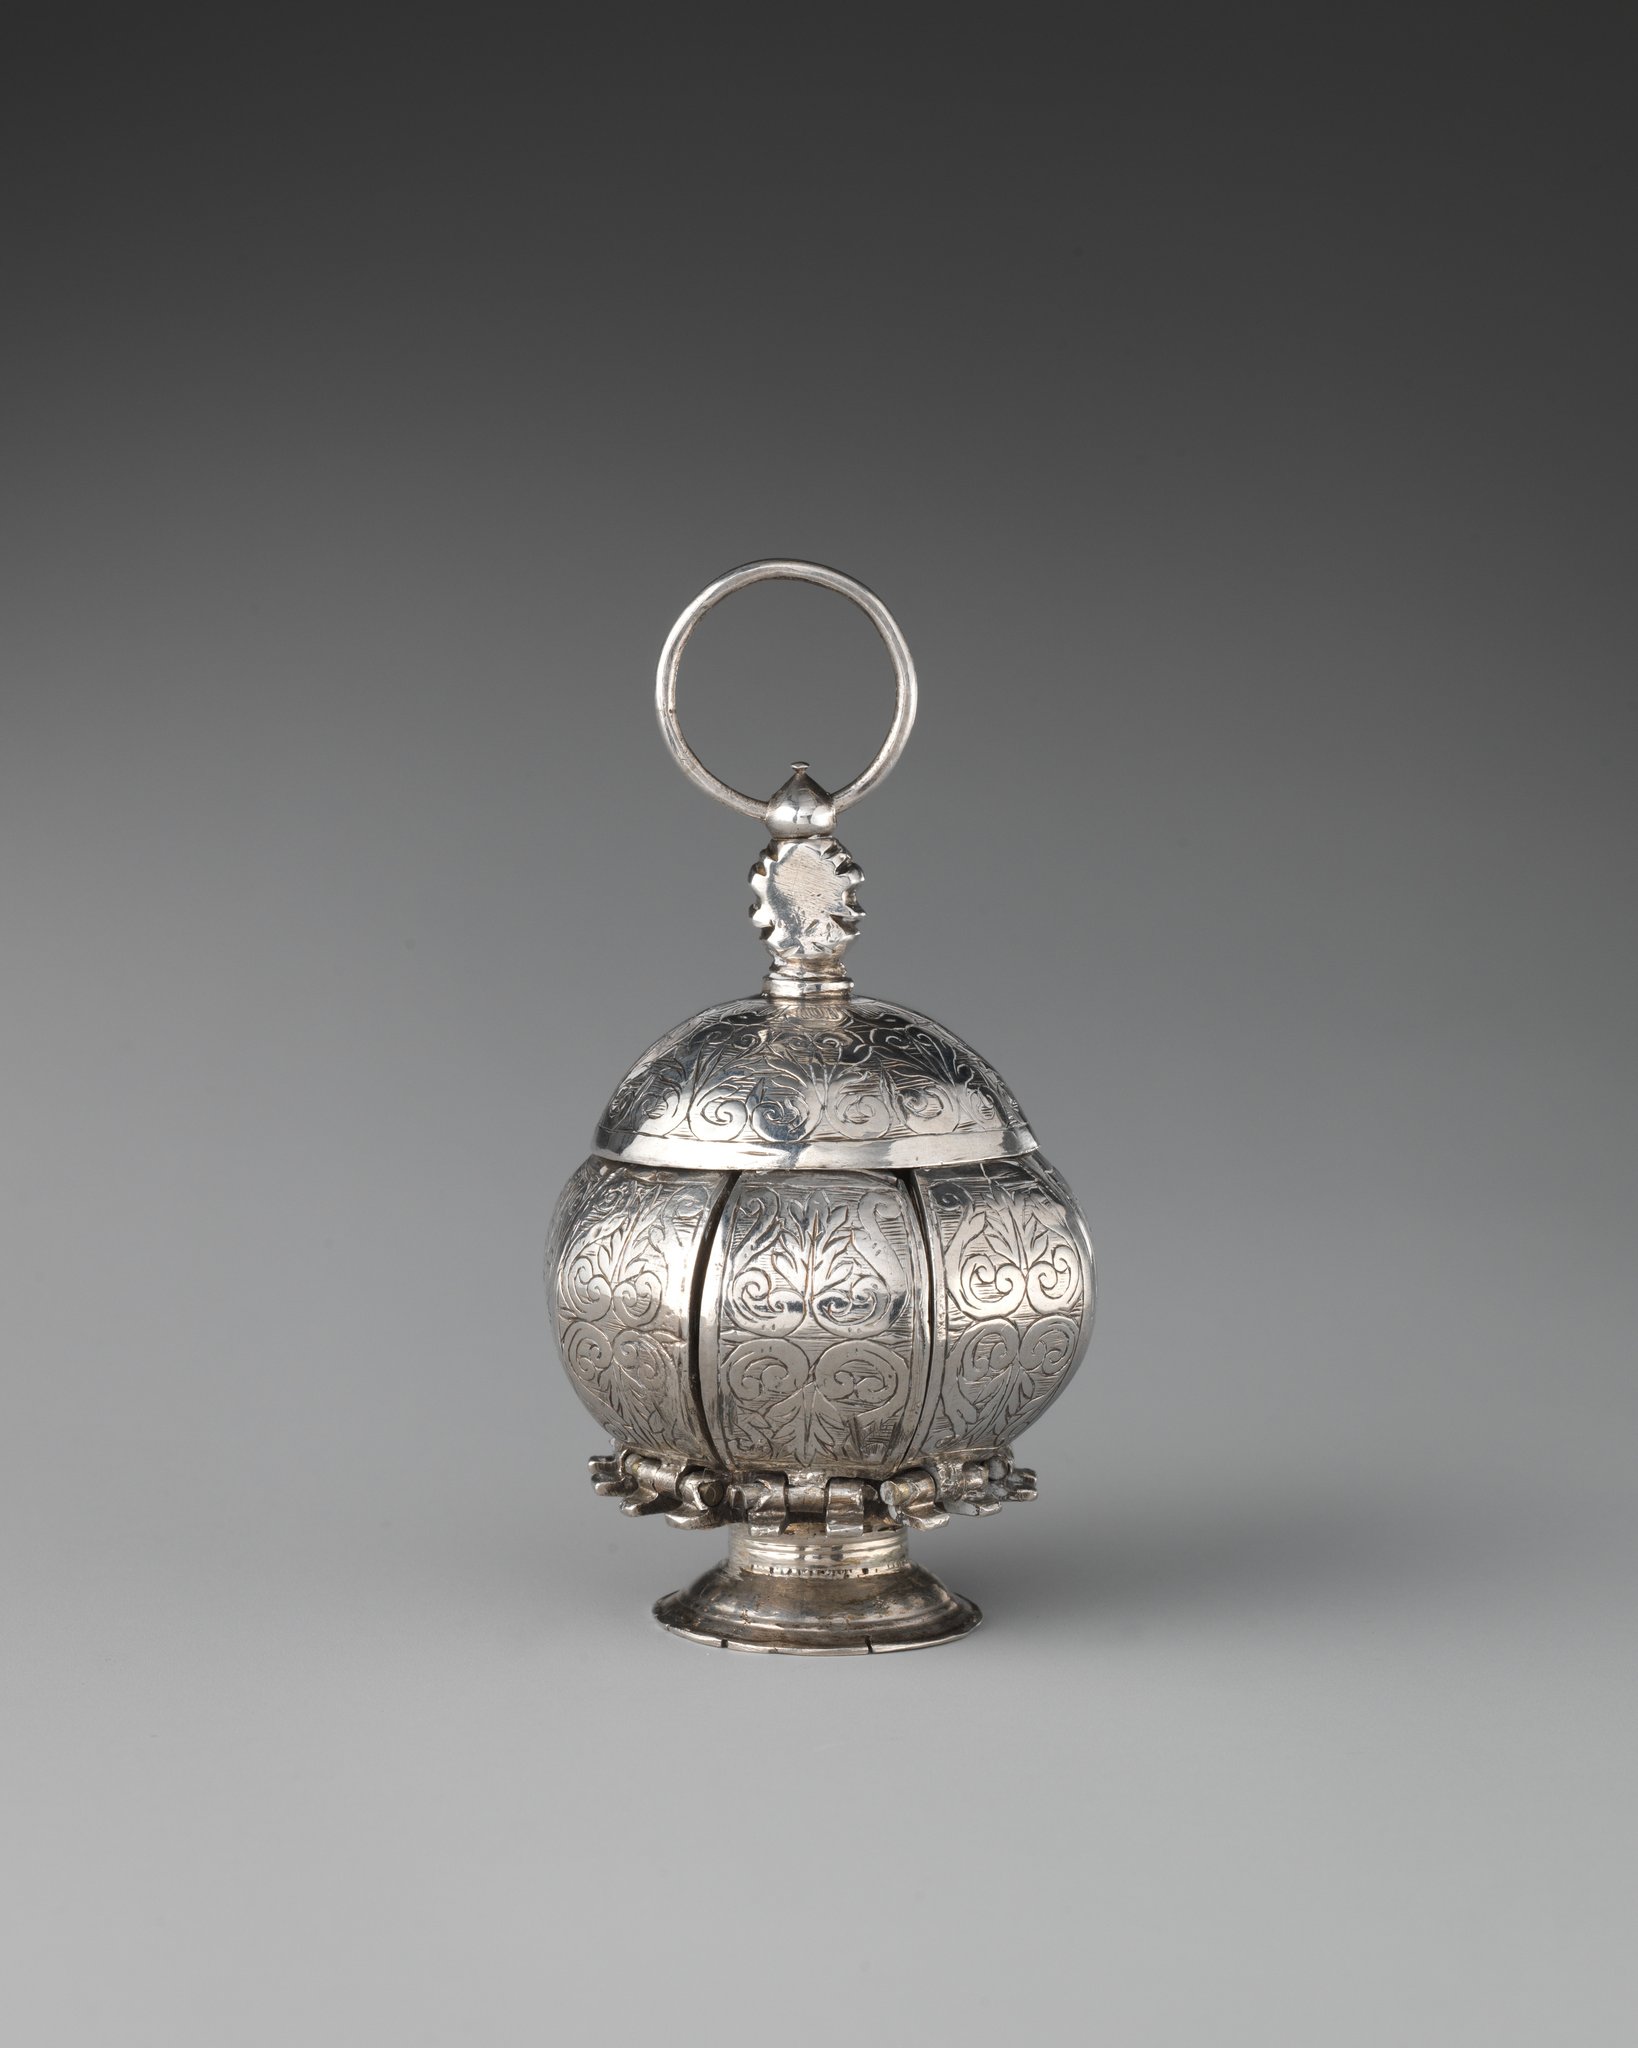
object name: pomander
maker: s. b.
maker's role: maker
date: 1580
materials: silver